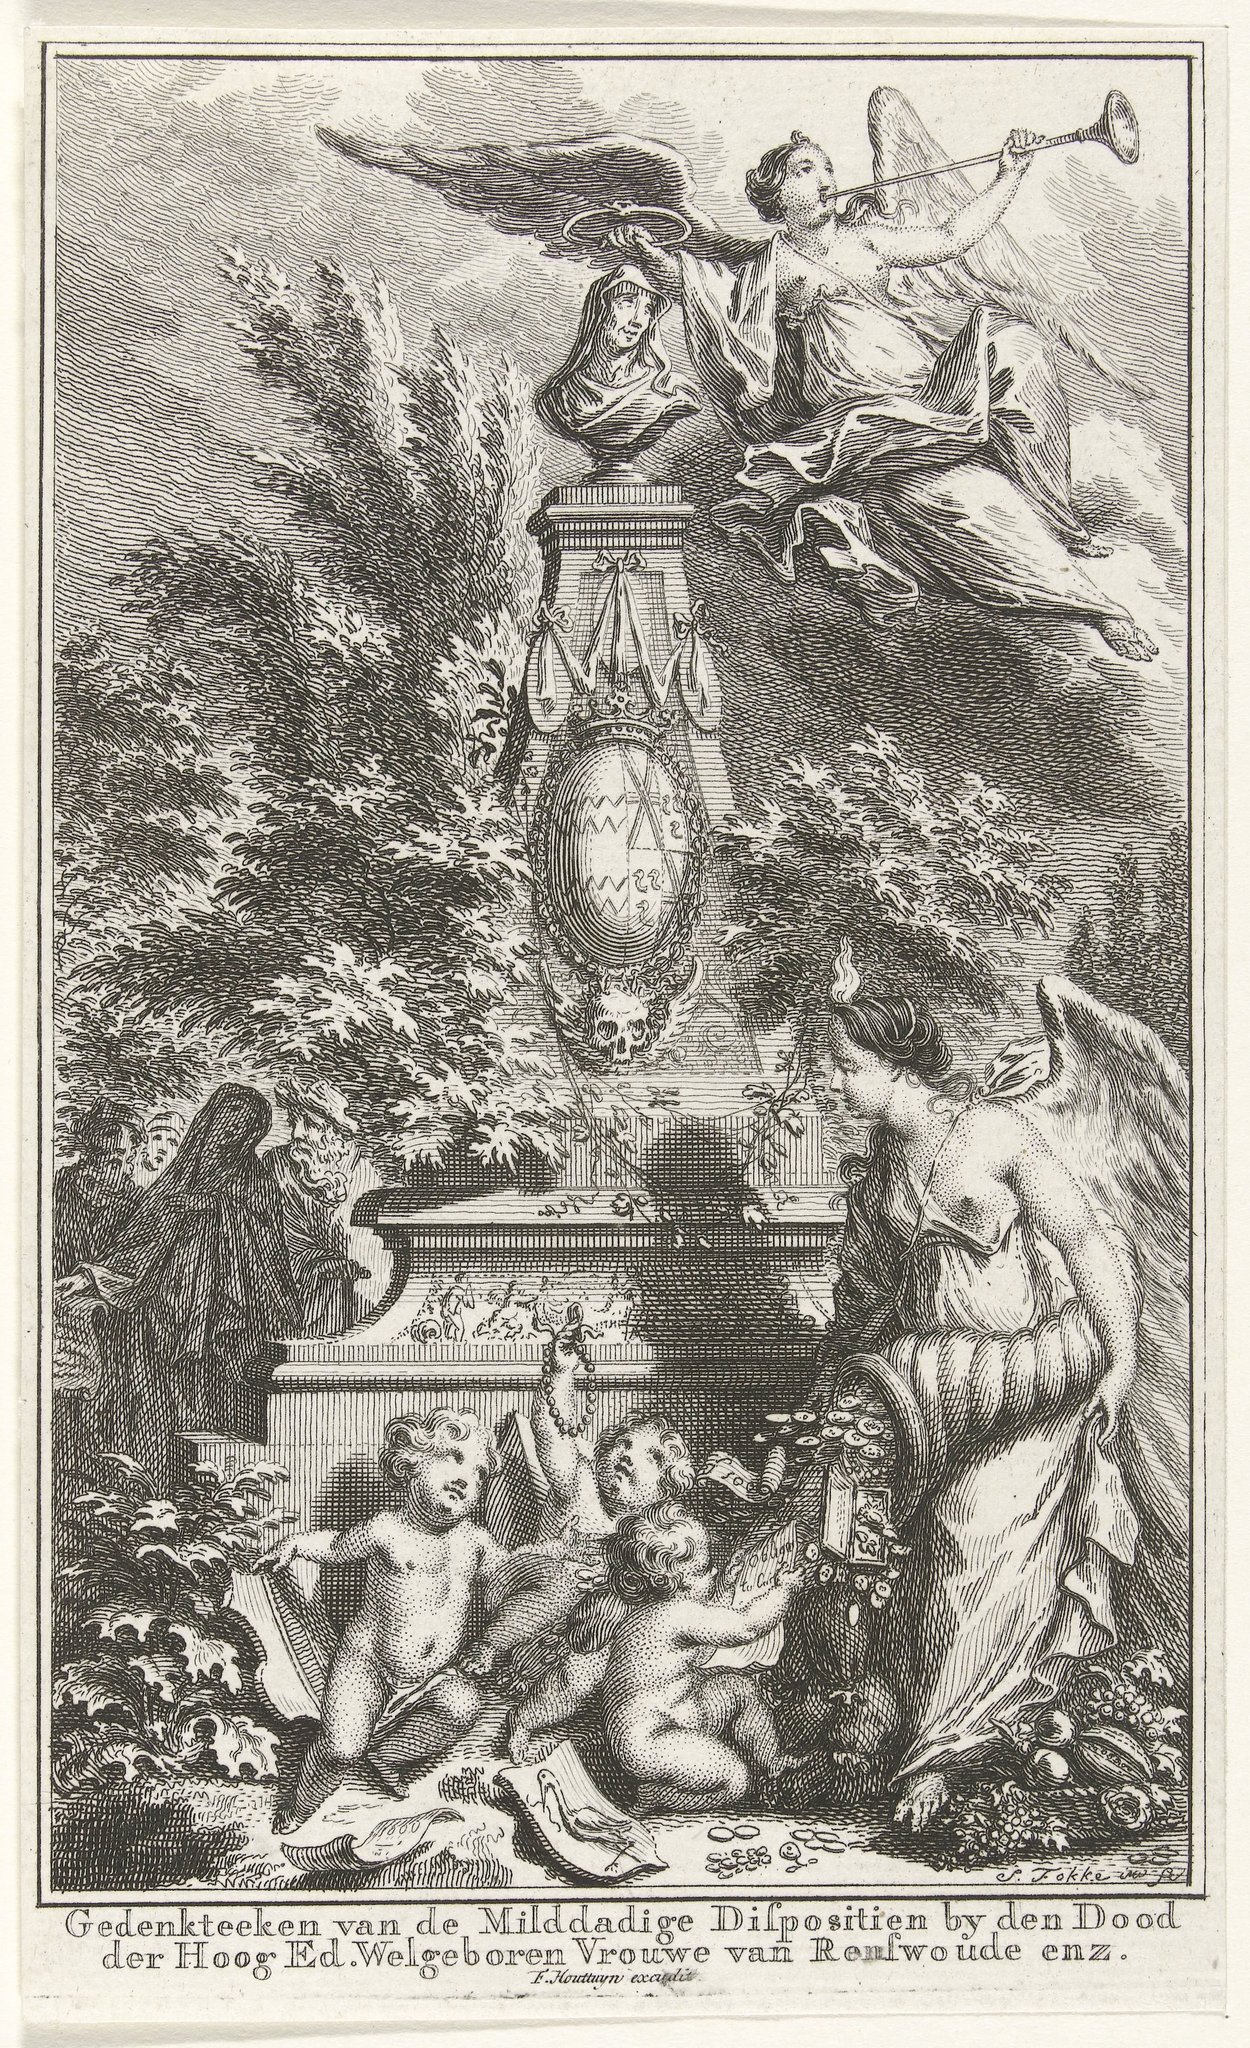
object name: print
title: Gedenkteeken van de Milddadige Dispositien by den Dood der Hoog Ed. Welgeboren Vrouwe van Renswoude enz.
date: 1754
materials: paper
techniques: engraving, etching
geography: northern netherlands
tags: delft, utrecht, grave-building, monumental tomb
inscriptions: collector's mark: Lugt 2228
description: Allegorisch grafmonument op het overlijden van Maria Duyst van Voorhout, vrijvrouwe van Renswoude, op 26 april 1754. Bij het monument stort de Milddadigheid een hoorn van overvloed gevuld met rijkdommen uit over drie kleine naakte jongetjes, symbool voor het vermogen dat Maria Duyst van Voorhout bij haar overlijden naliet aan het armenonderwijs (Fundaties van Renswoude). Bovenop het monument een portretbuste, in de wolken blaast Fortuin op haar bazuin.